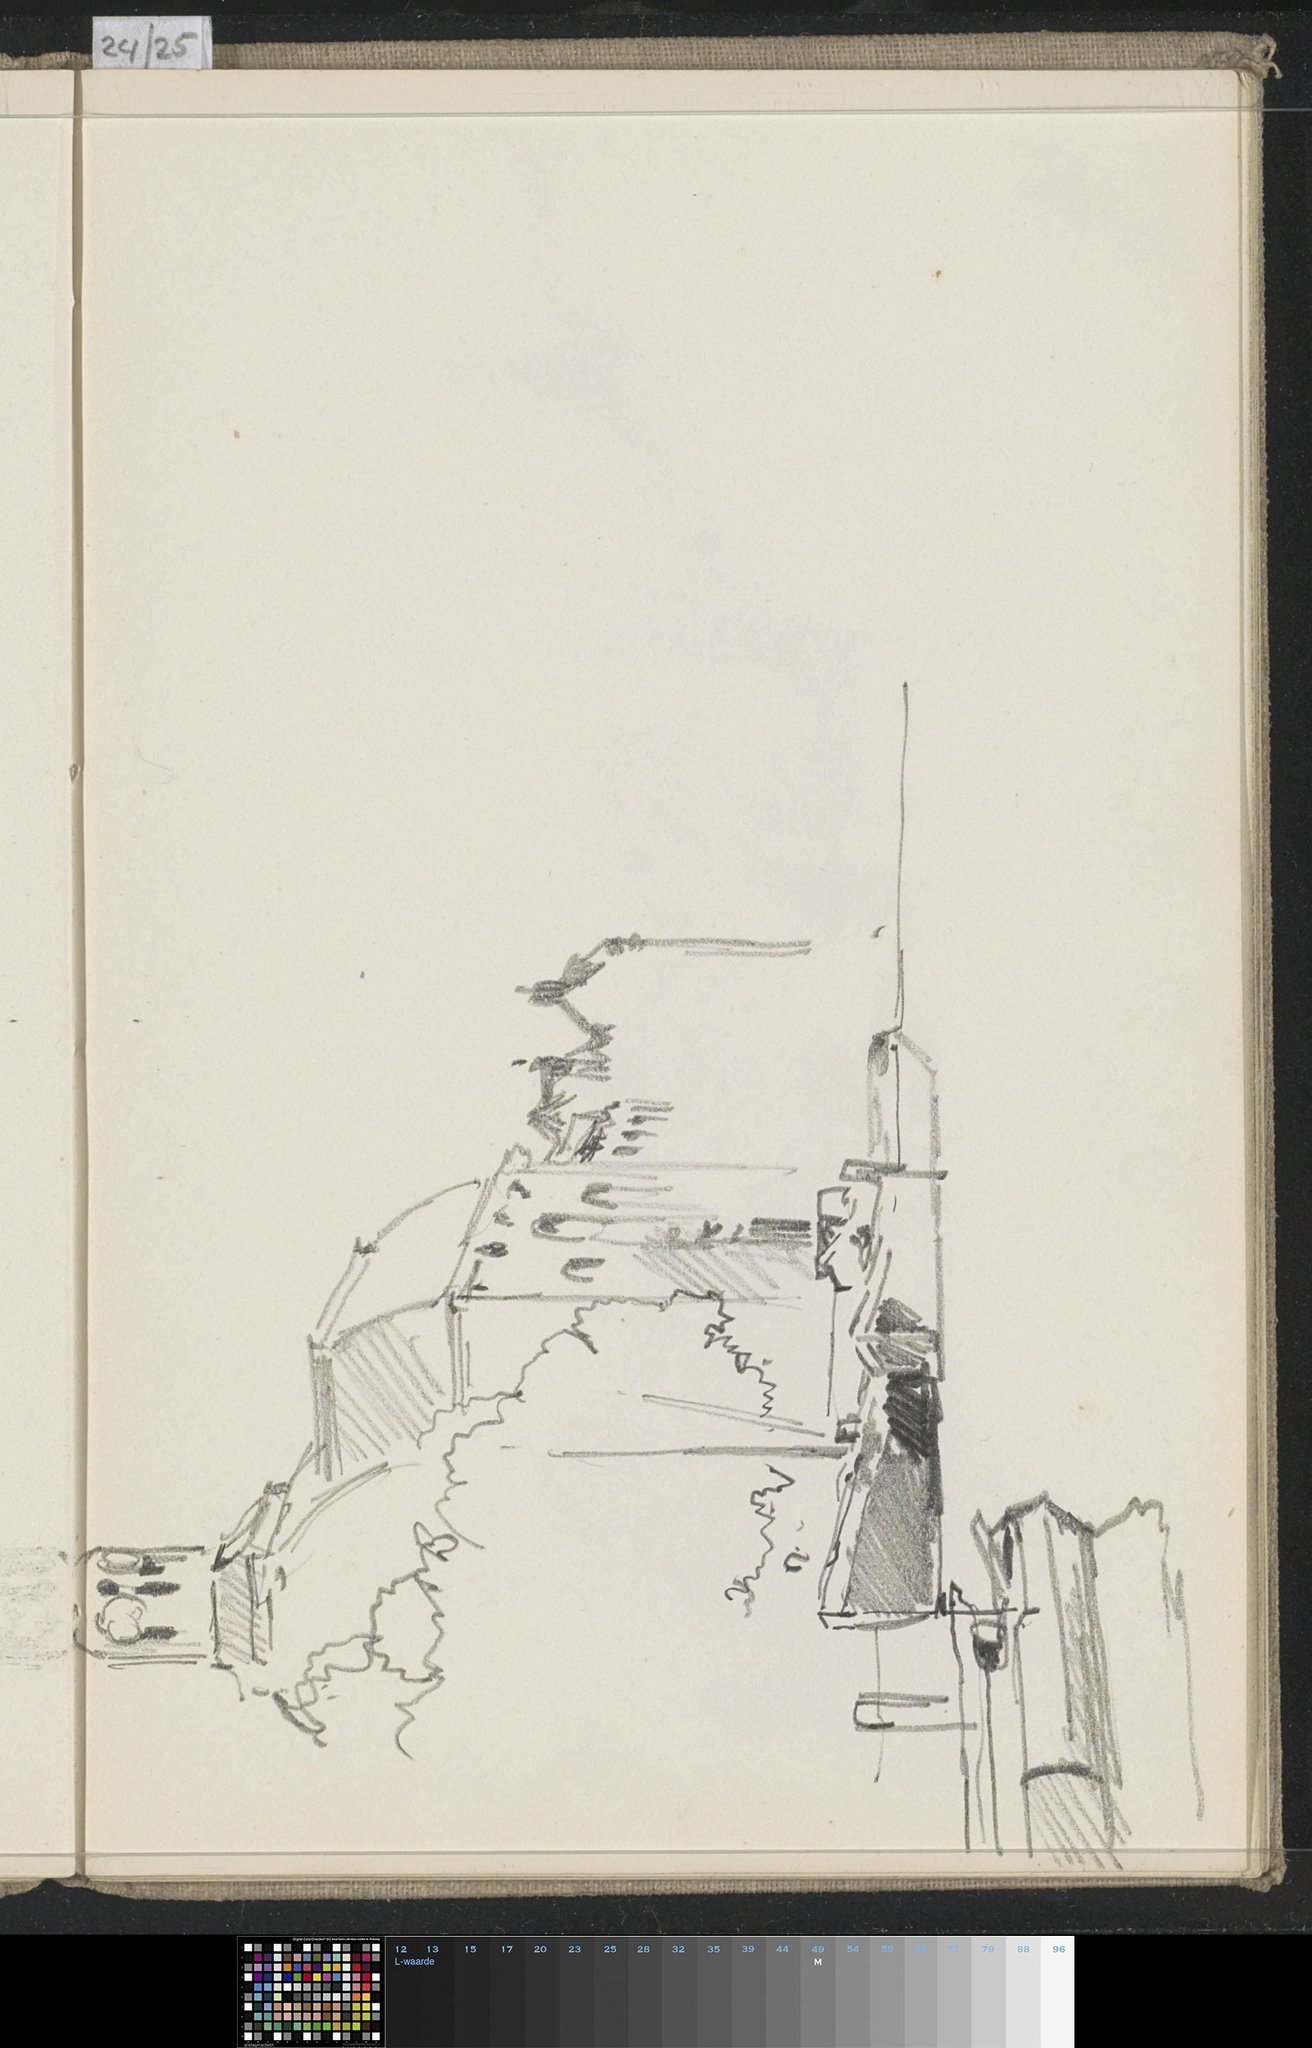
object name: sketchbook leaf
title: Boten aangemeerd bij een kade voor een gebouw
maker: cornelis vreedenburgh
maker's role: draughtsman, print maker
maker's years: 1880-1946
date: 1890-1946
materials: paper, pencil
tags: city-view, and landscape with man-made constructions, sailing-ship, sailing-boat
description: Blad 21 recto uit een schetsboek met 41 bladen.